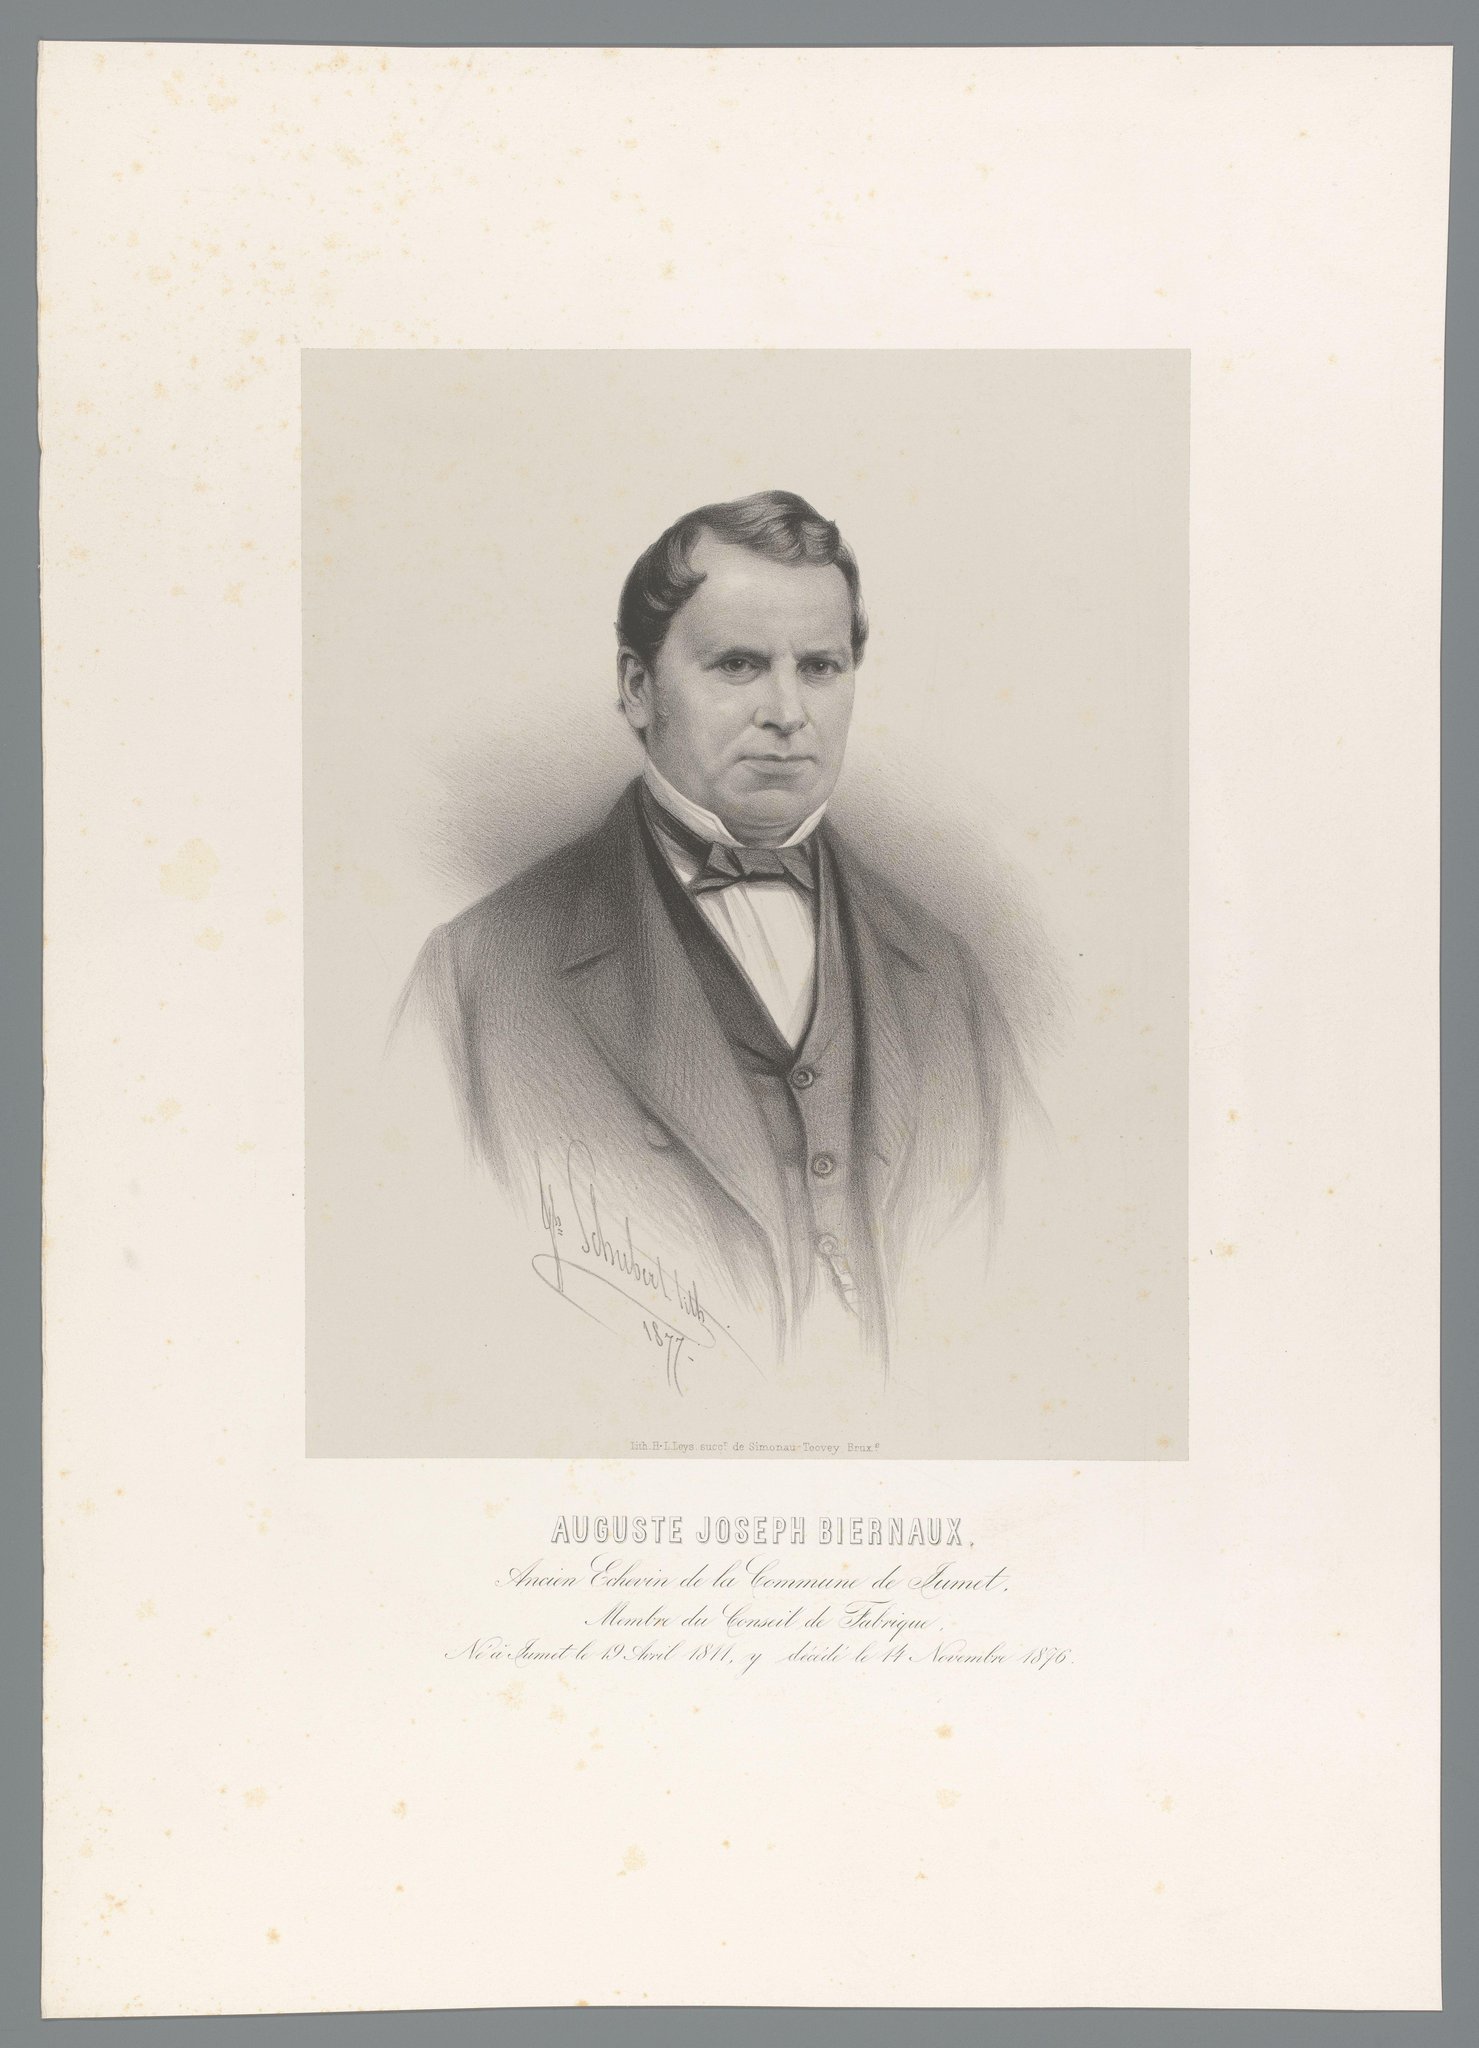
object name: print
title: Auguste Joseph Biernaux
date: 1877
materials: paper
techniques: lithograph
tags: auguste joseph biernaux, historical persons, politician, e.g. party leader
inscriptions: collector's mark: Lugt 2228